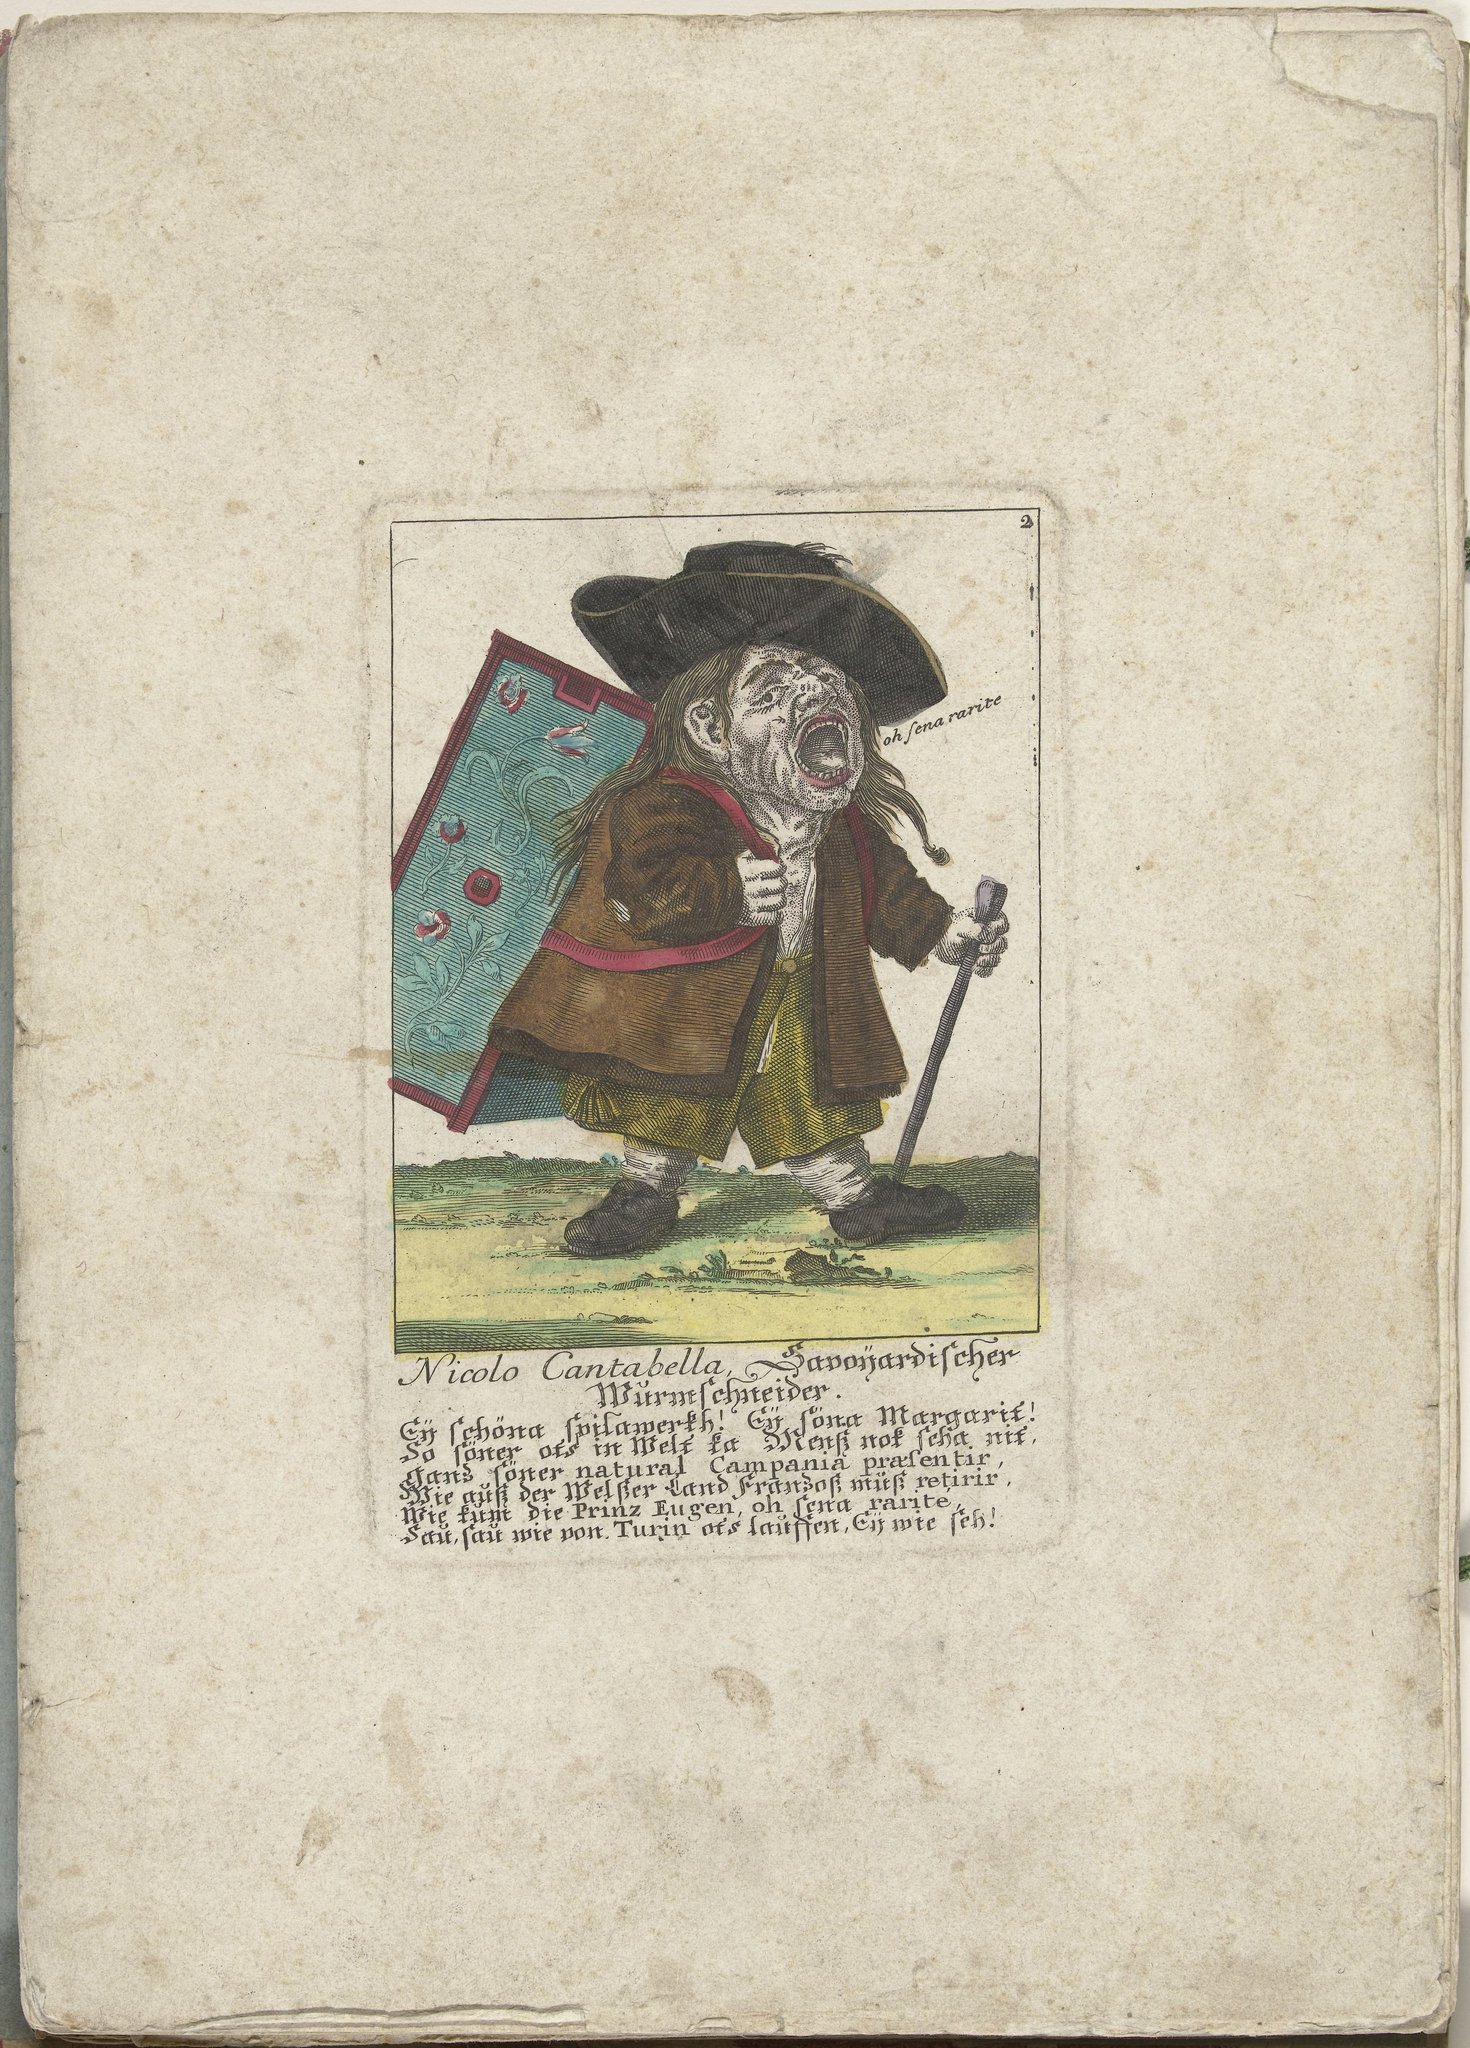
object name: caricature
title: Nicolo Cantabella, Savoijardischer Wurmschneider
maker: martin engelbrecht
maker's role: print maker, publisher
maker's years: 1684-1756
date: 1705-1715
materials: paper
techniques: engraving, etching, hand coloring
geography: augsburg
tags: caricatures (human types), little people, quack, charlatan, mountebank, 'saltimbanco'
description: Roepende kleine mens Nicolo Cantabella uit Savoye als kwakzalver met een koffer op de rug. In het onderschrift onder de titel een zesregelig vers in het Duits. Genummerd rechtsboven: 2. Onderdeel van een losbladige uitgave uit ca. 1710 van een serie karikaturen van kleine mensen, bekend als Het Dwergentooneel.